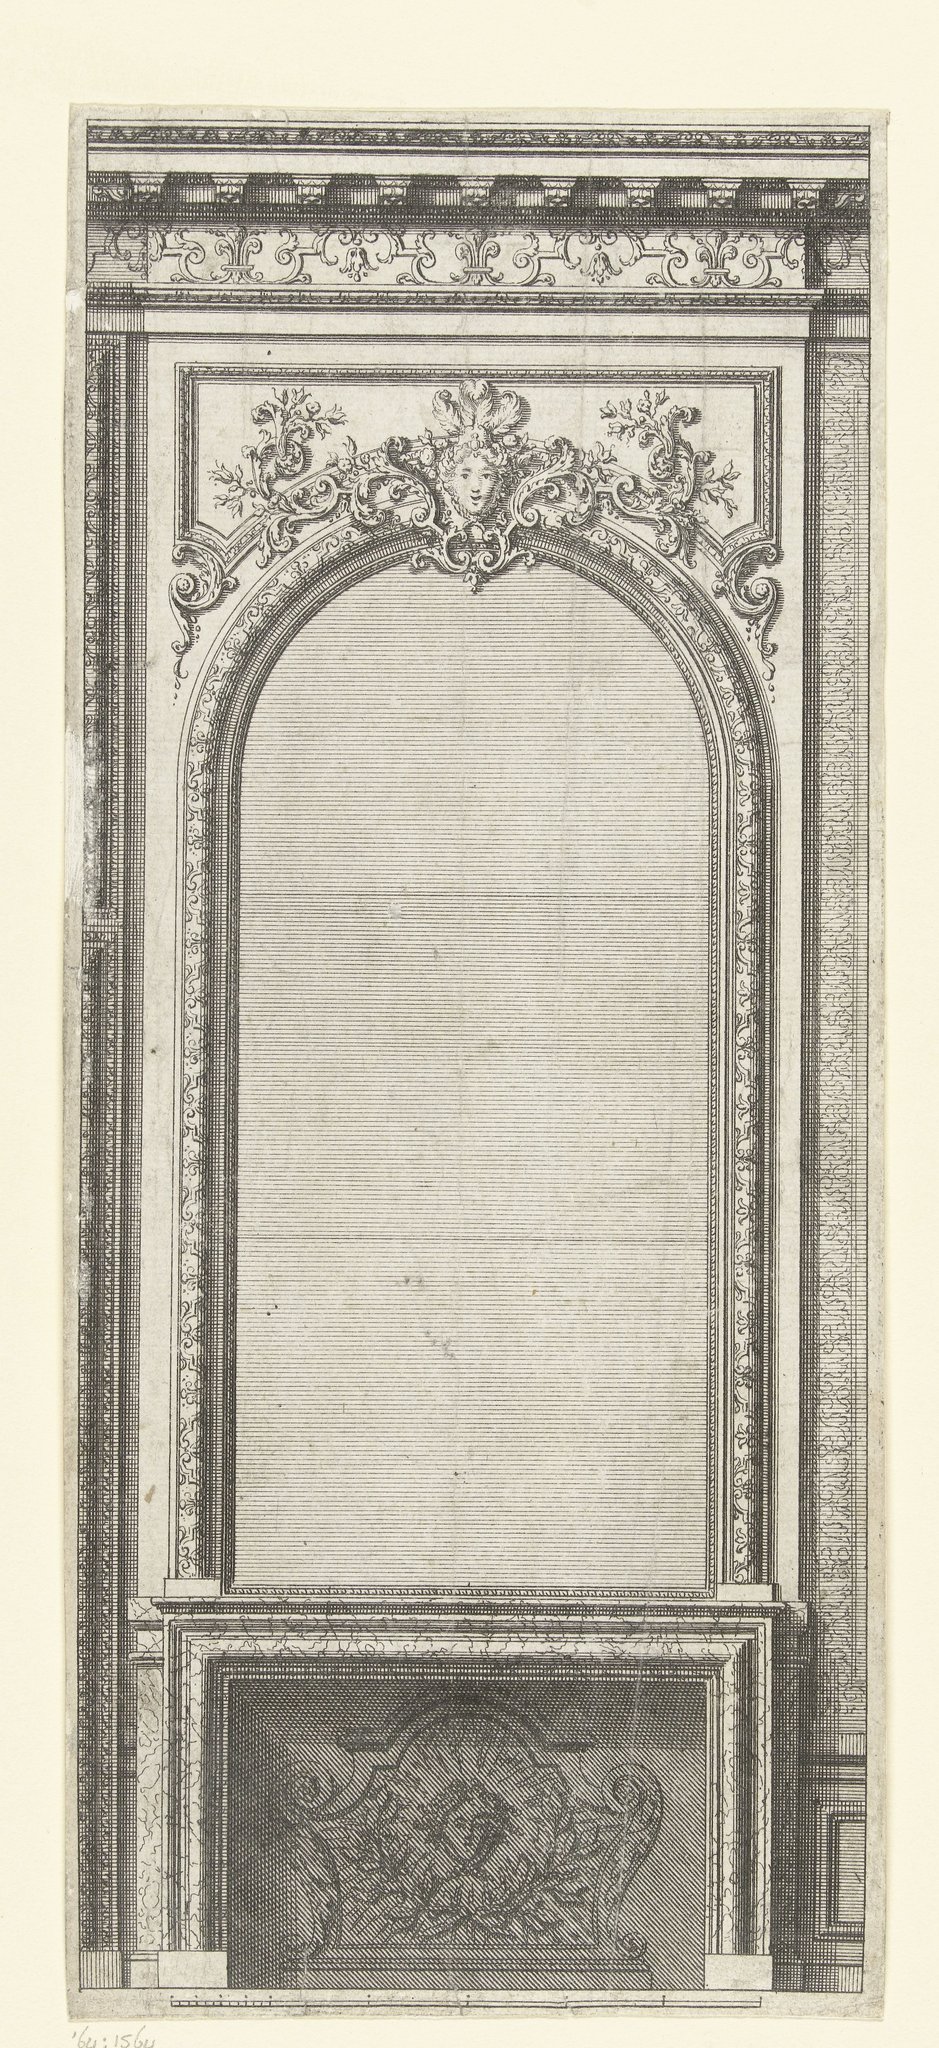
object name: print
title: Schoorsteen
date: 1670-1699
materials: paper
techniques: etching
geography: france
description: Niet in Berlin. Guilmard. Zie Fishe Kimball, The Creation of the Rococo, p.68 (vermeld reeks in Met.Mus.N.Y. als uniek). Zie ook: Metrop.Mus. Studies, Vol. V, p.274 e.v.